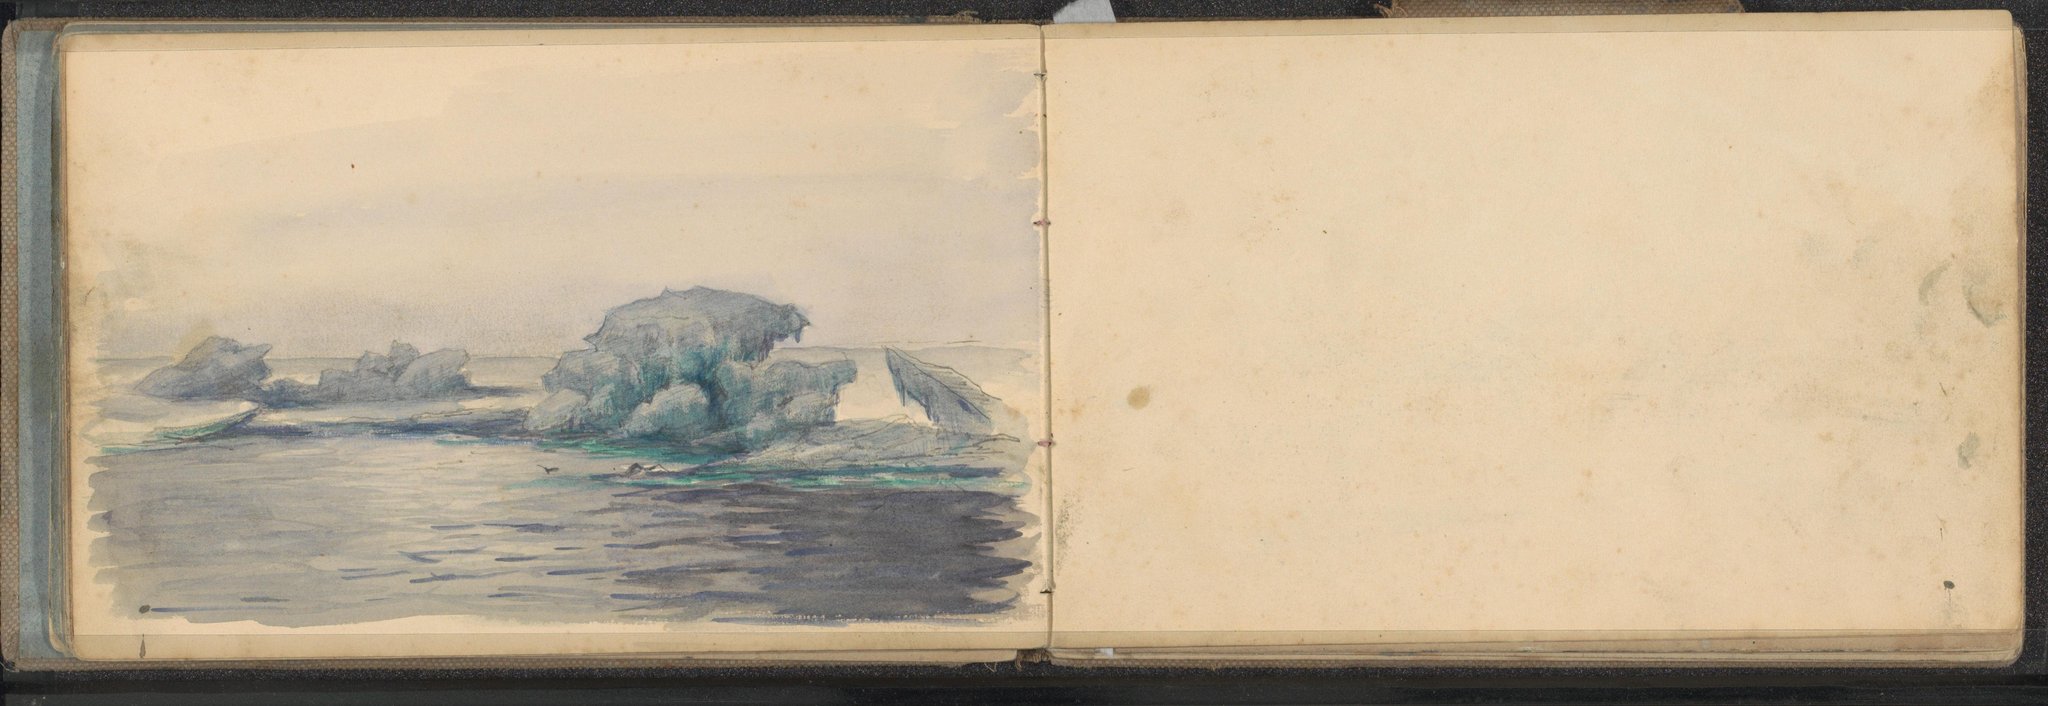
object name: sketchbook leaf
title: Gezicht op de Barentszzee met ijsbergen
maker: louis apol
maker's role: draughtsman, painter, print maker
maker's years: 1850-1936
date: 1880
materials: paper, pencil, watercolor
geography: barentsz sea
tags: iceberg, sea (seascape)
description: Blad 18 verso uit een schetsboek met 35 bladen betekend tijdens de expeditie naar Nova Zembla in 1880.